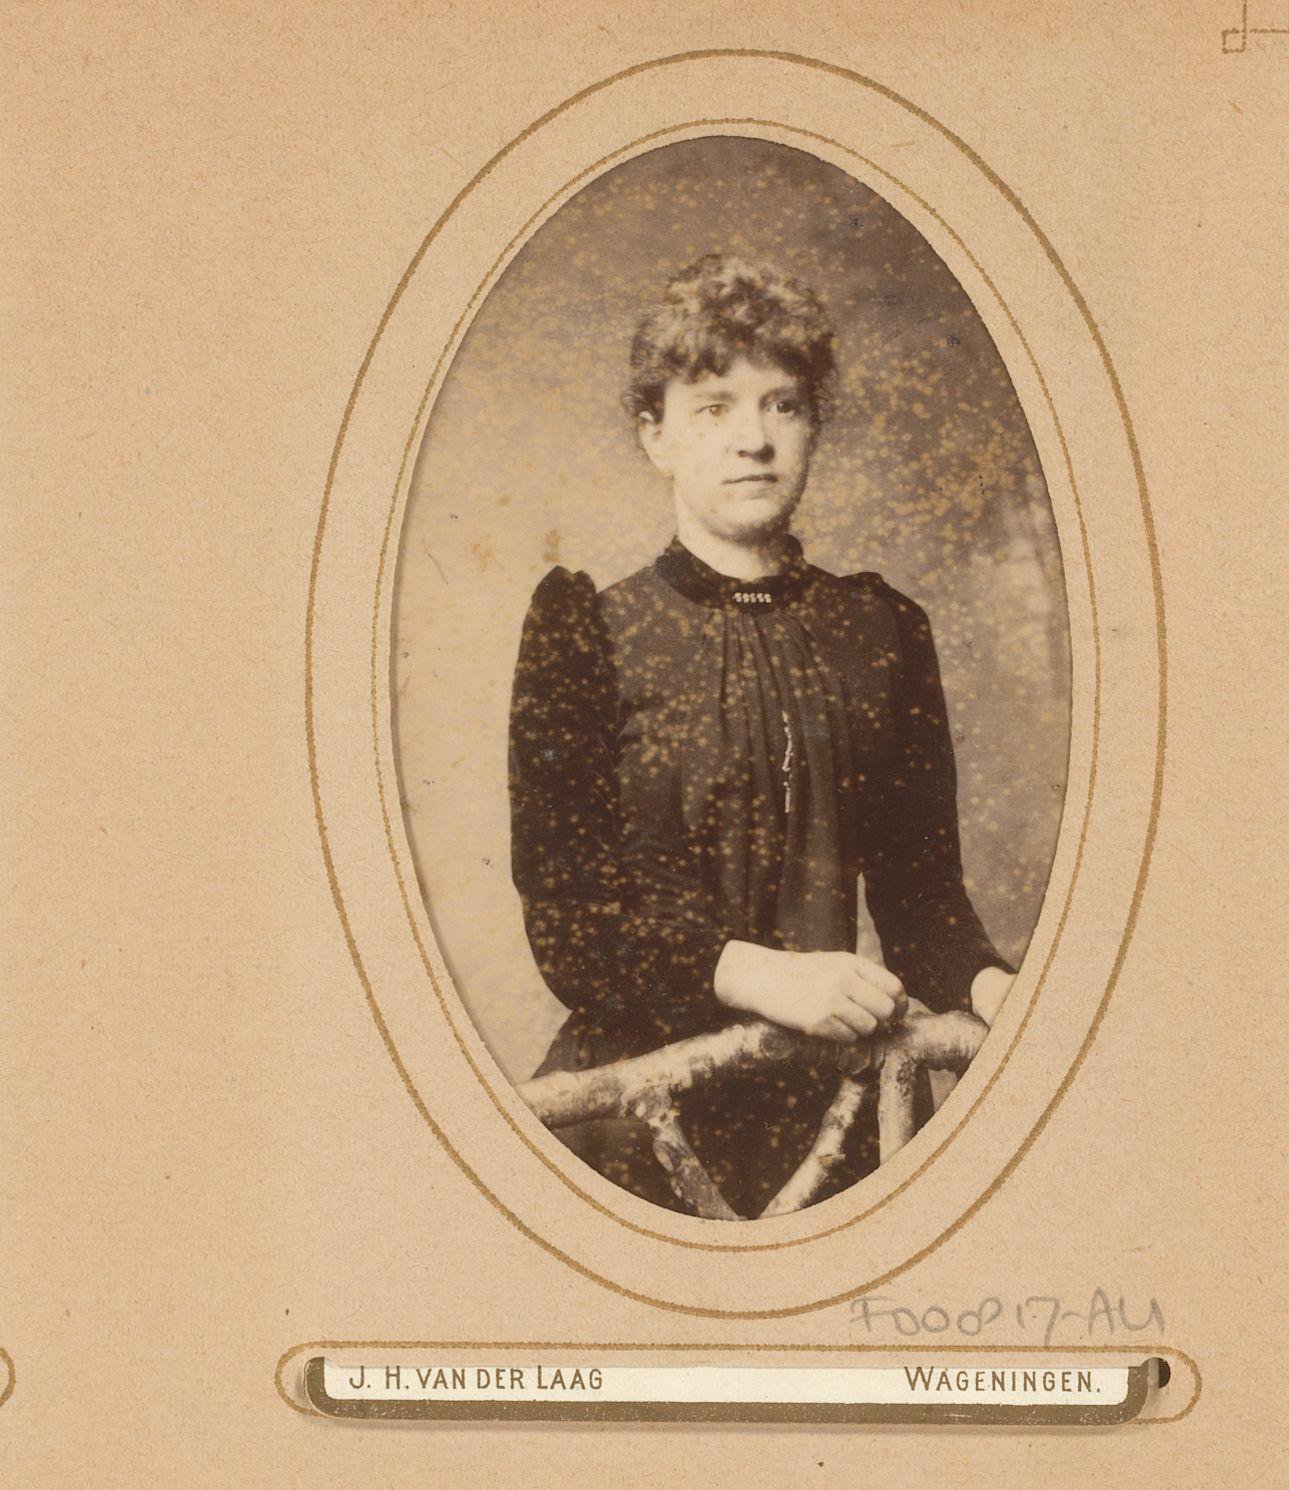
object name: album leaf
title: Portret van een staande vrouw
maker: johan herman van der laag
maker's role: fotograaf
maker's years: 1865-1937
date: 1895-1920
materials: cardboard, photographic support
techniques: albumen print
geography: wageningen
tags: historical persons - bb - woman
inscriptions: inscription: ‘Photographisch/ Atelier/ J.H. van der Laag/ Wageningen/ naast het Station’